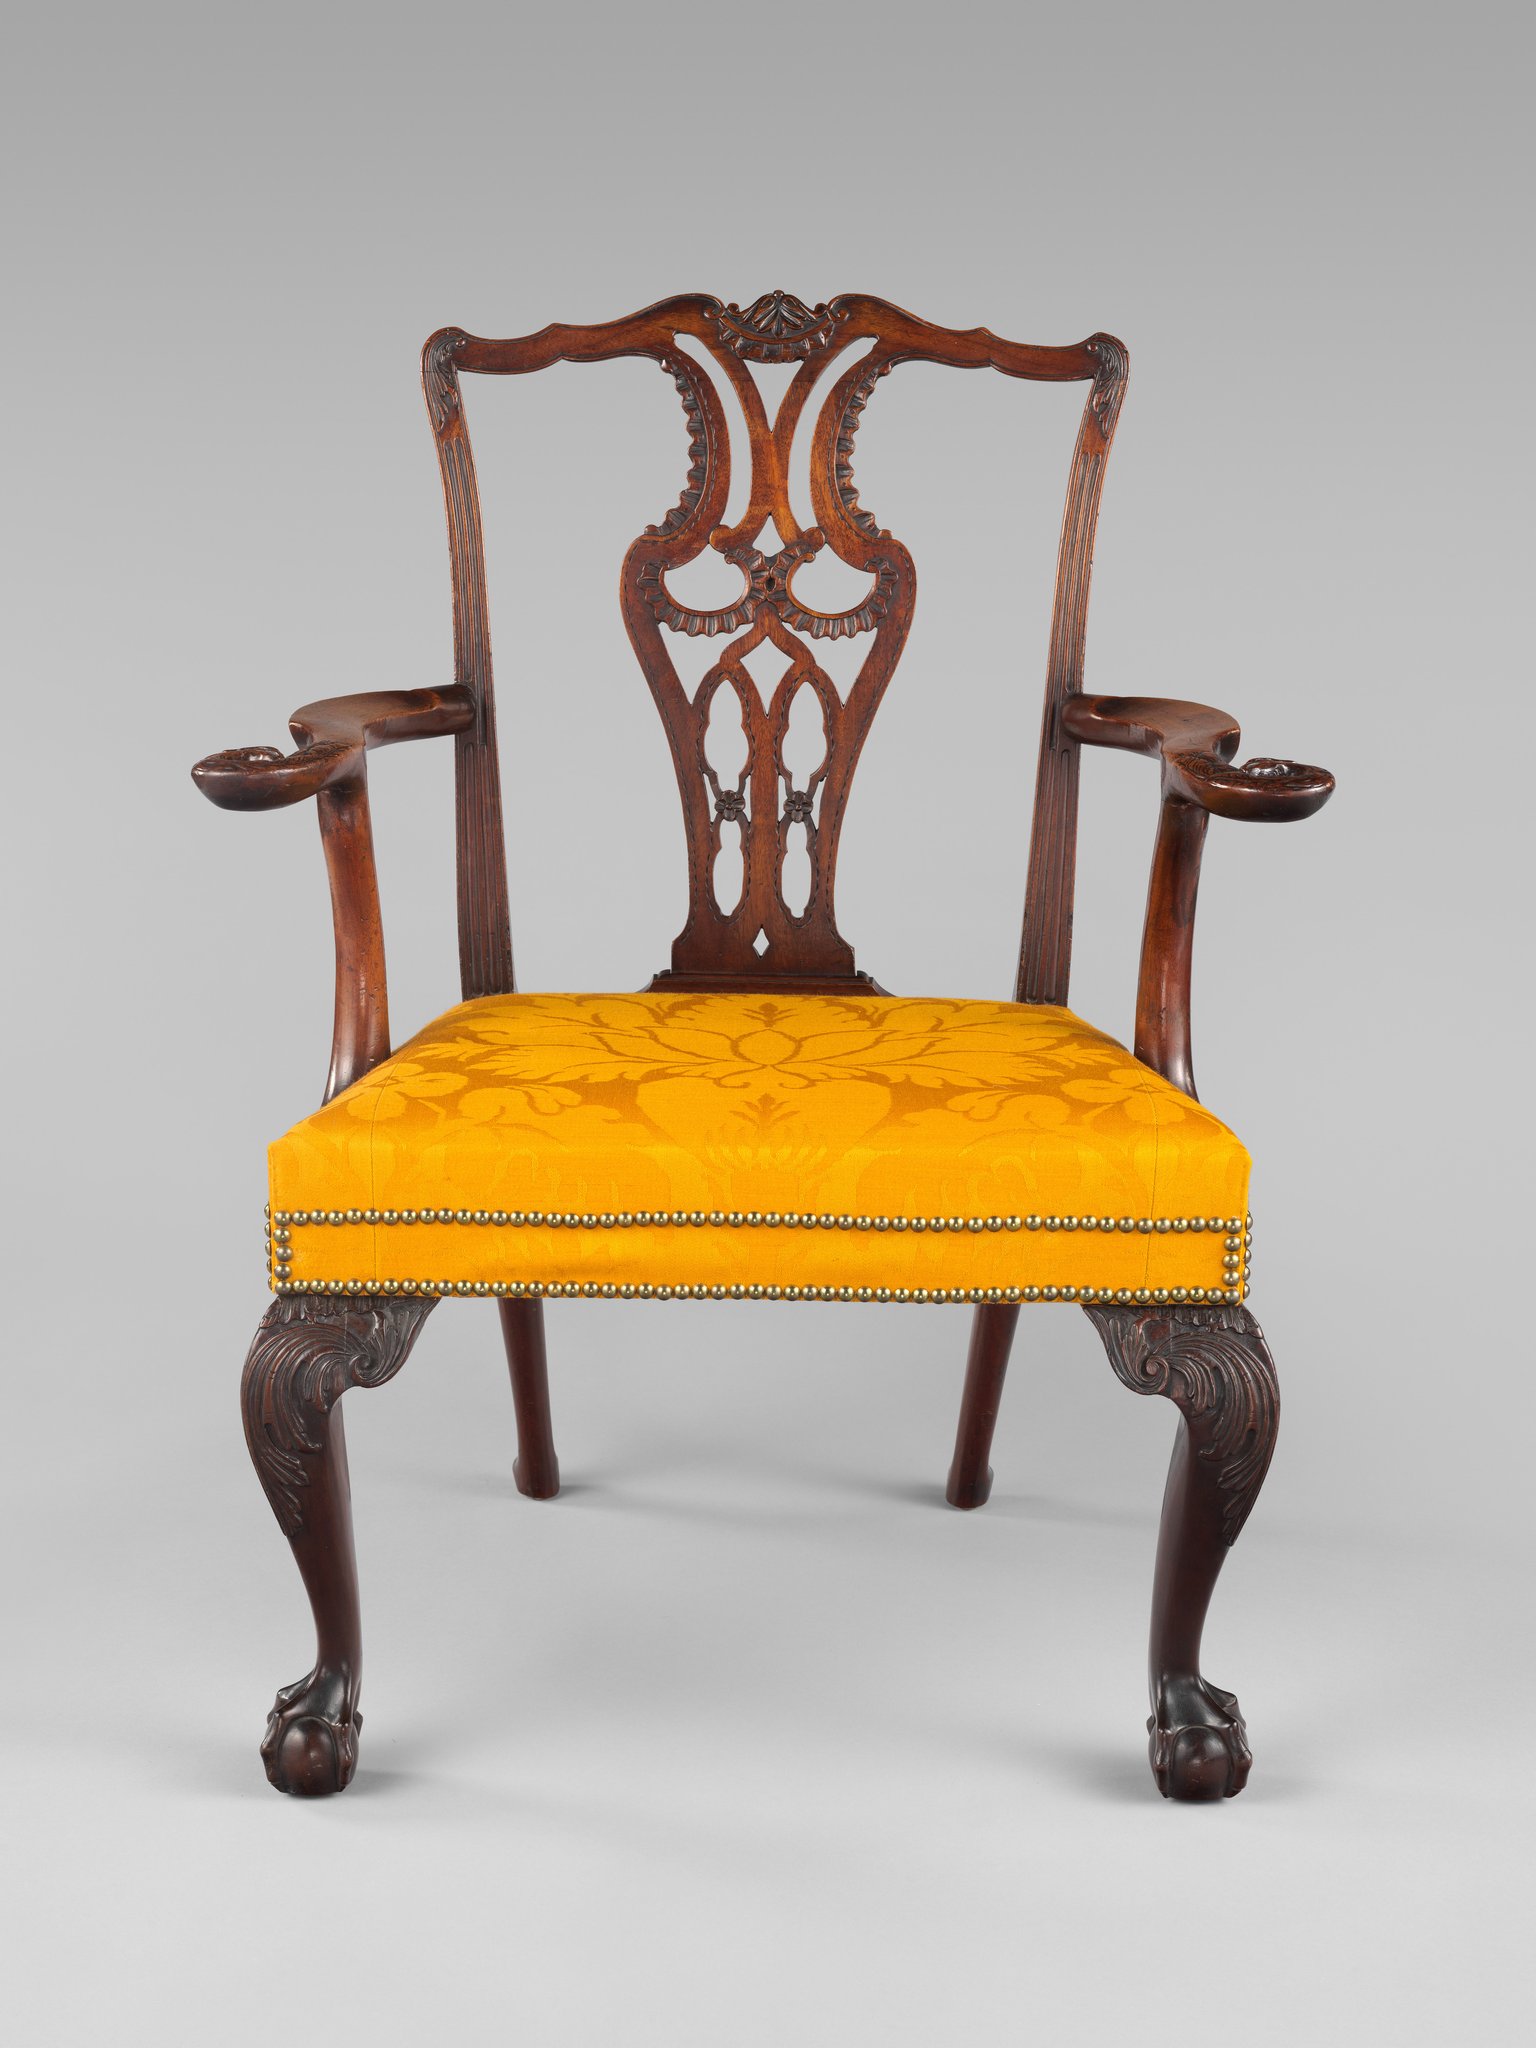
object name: armchair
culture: american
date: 1770-1790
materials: wood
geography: united states